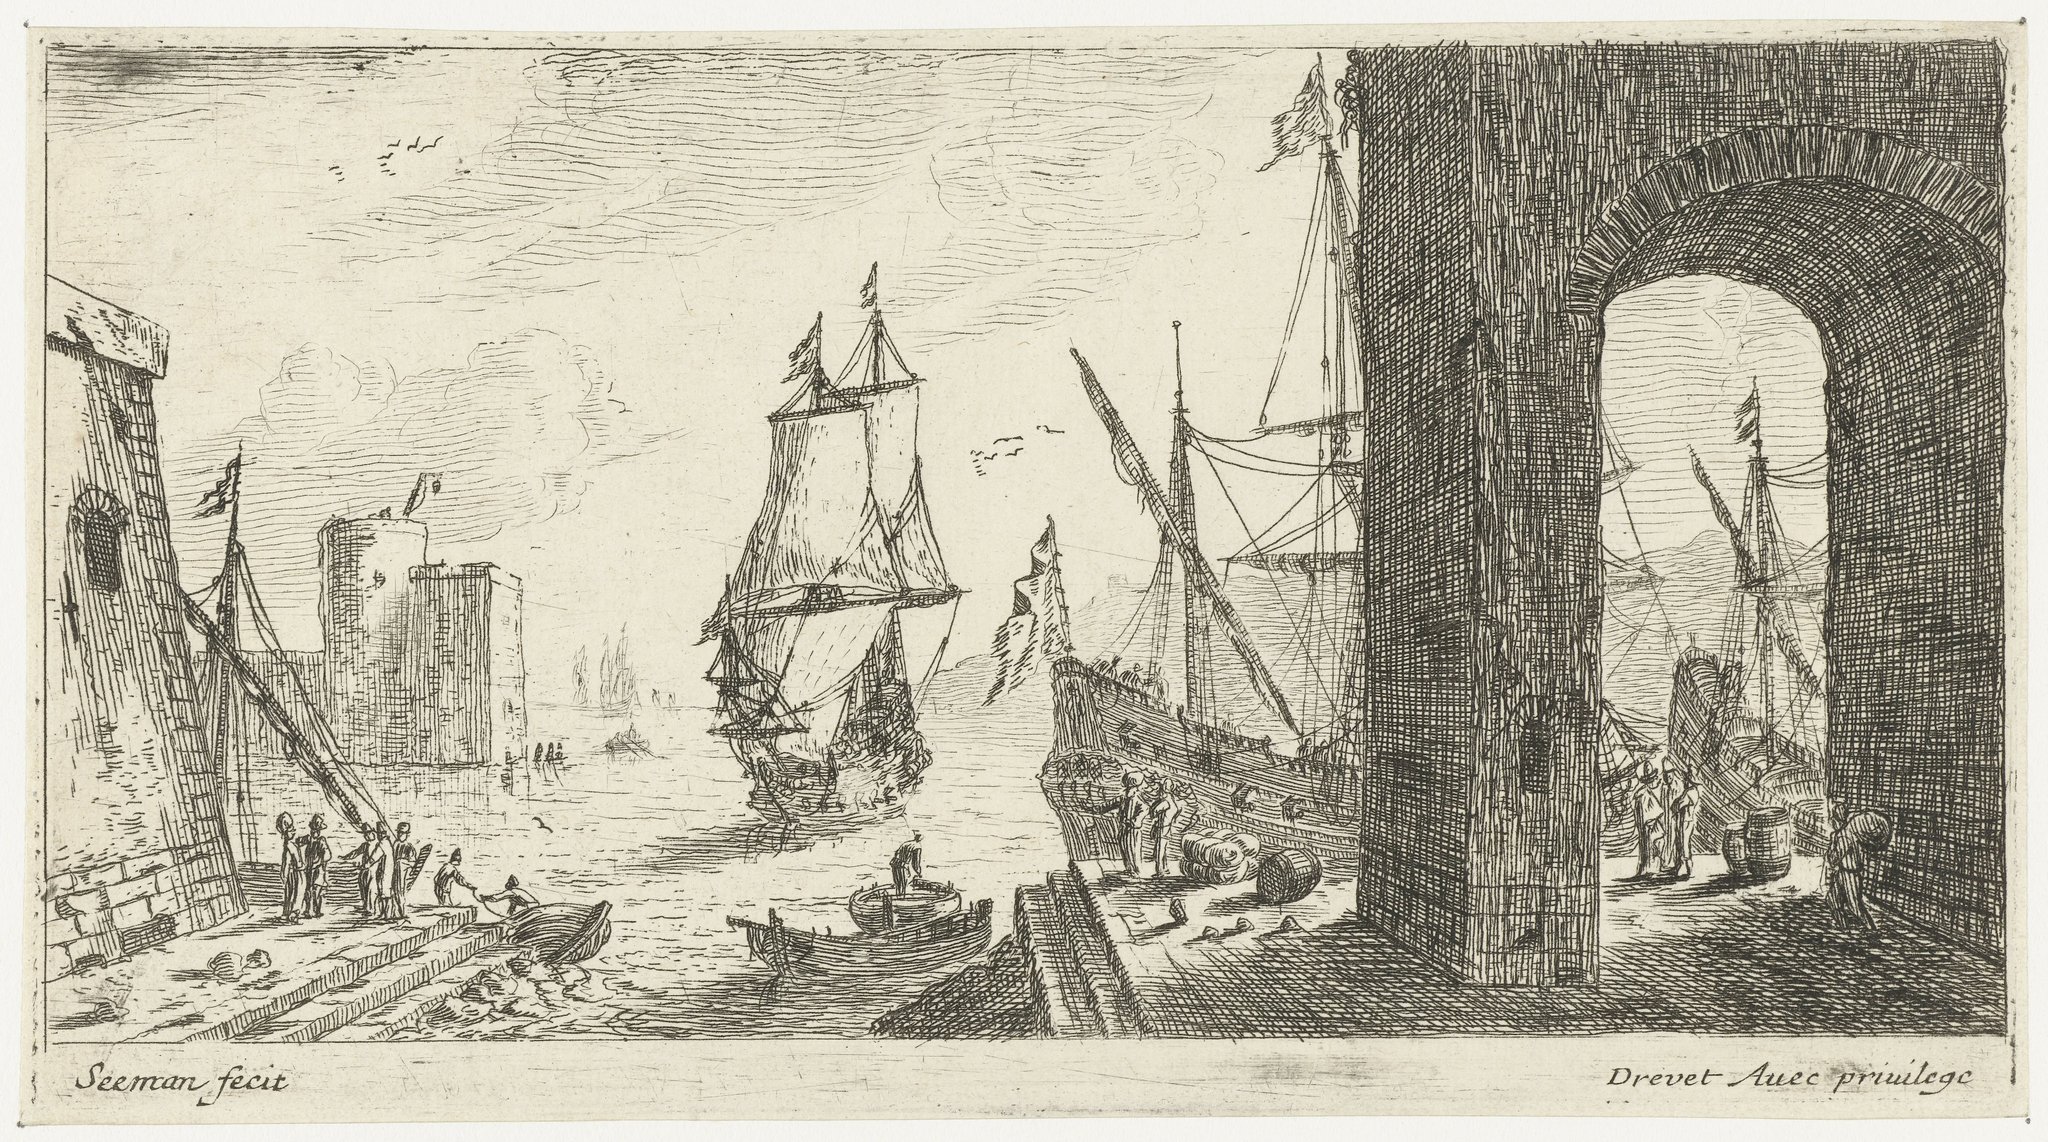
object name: print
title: Grote boog op de kade van een haven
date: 1650-1738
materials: paper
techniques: etching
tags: harbour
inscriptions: collector's mark: Lugt 2228a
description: Haven met een aantal zeilschepen. Op de kade grote stenen boog.